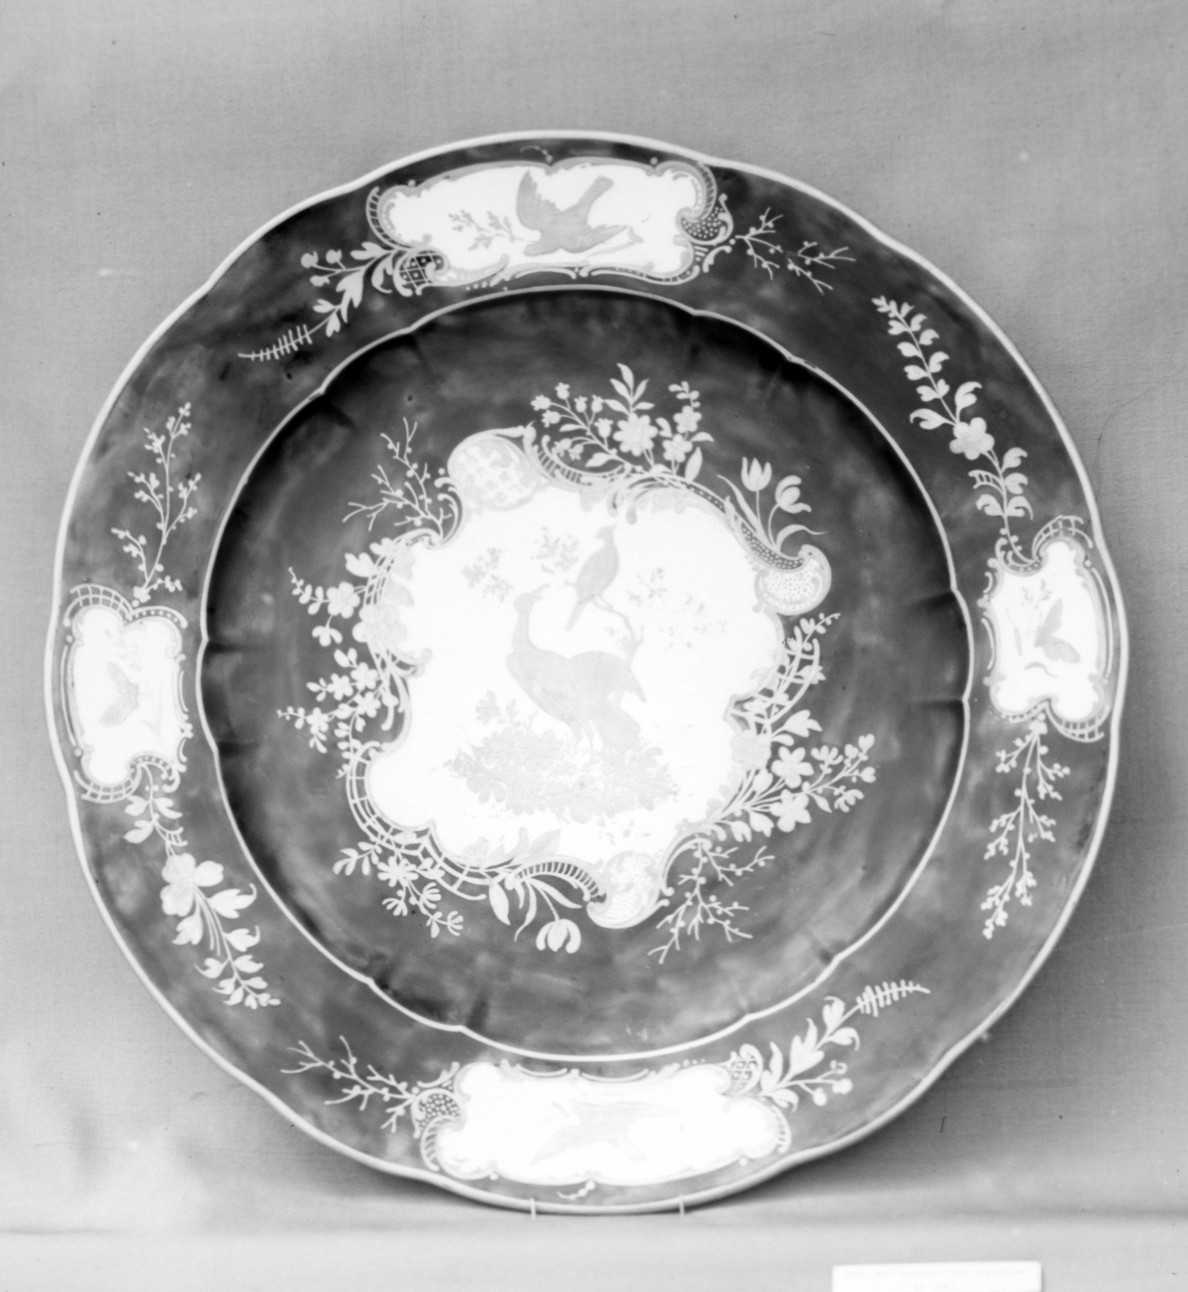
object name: plate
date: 1801-1900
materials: soft paste porcelain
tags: birds,flowers